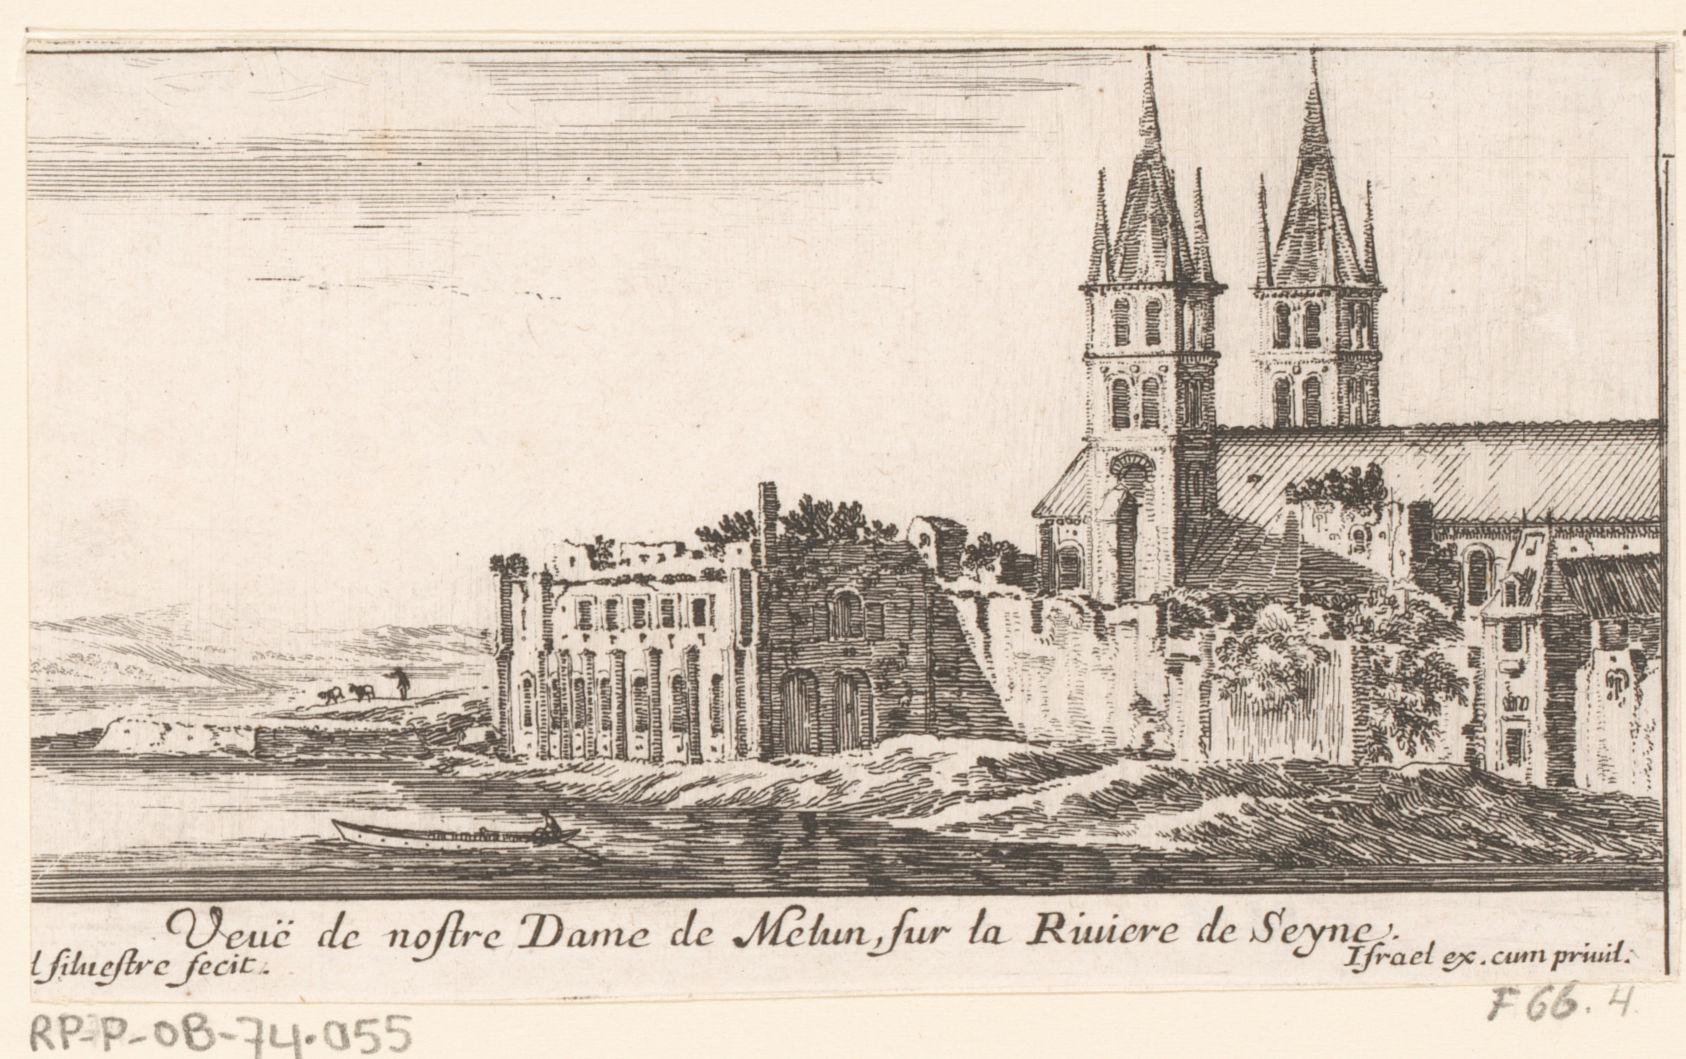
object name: print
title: Gezicht op kerken in en om Parijs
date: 1631-1661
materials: paper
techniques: engraving, etching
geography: france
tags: landscape with tower or castle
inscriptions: collector's mark: Lugt 240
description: Prent maakt deel uit van een ongenummerde serie van negen prenten.